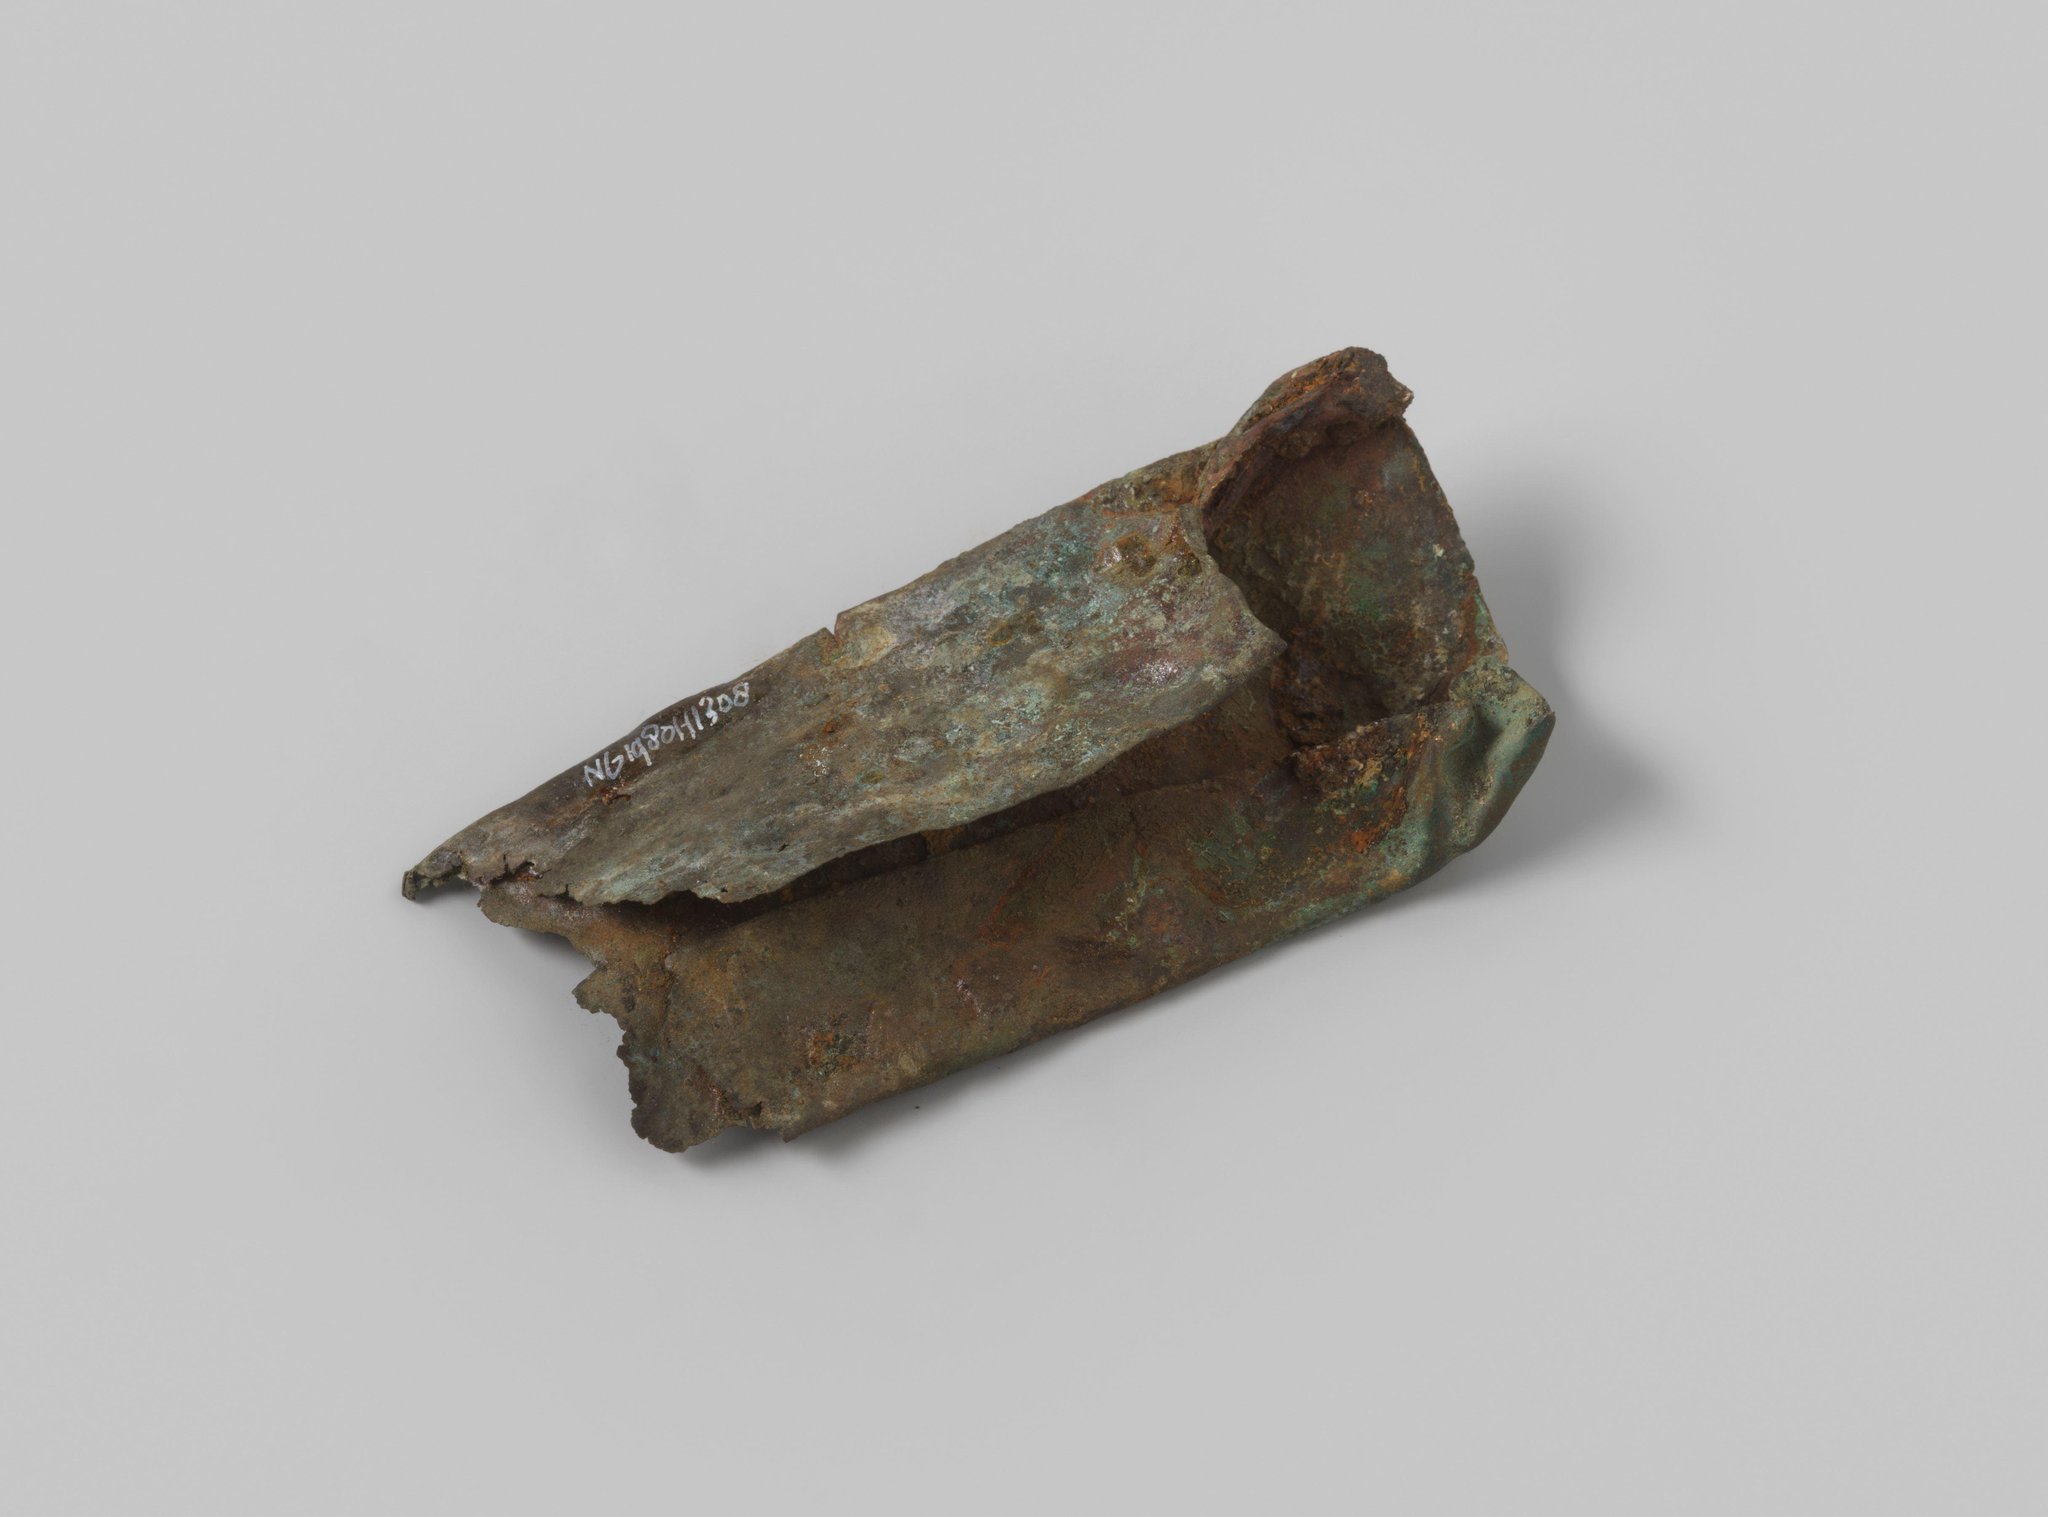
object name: cartridge shell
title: Patroonhuls uit het wrak van de Oost-Indiëvaarder Hollandia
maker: Anonymous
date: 1700-1743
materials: copper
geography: netherlands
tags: verenigde oostindische compagnie, hollandia (schip), annet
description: Cartridge case, tube; fragm, squashed, id. NG 1979-205H549.